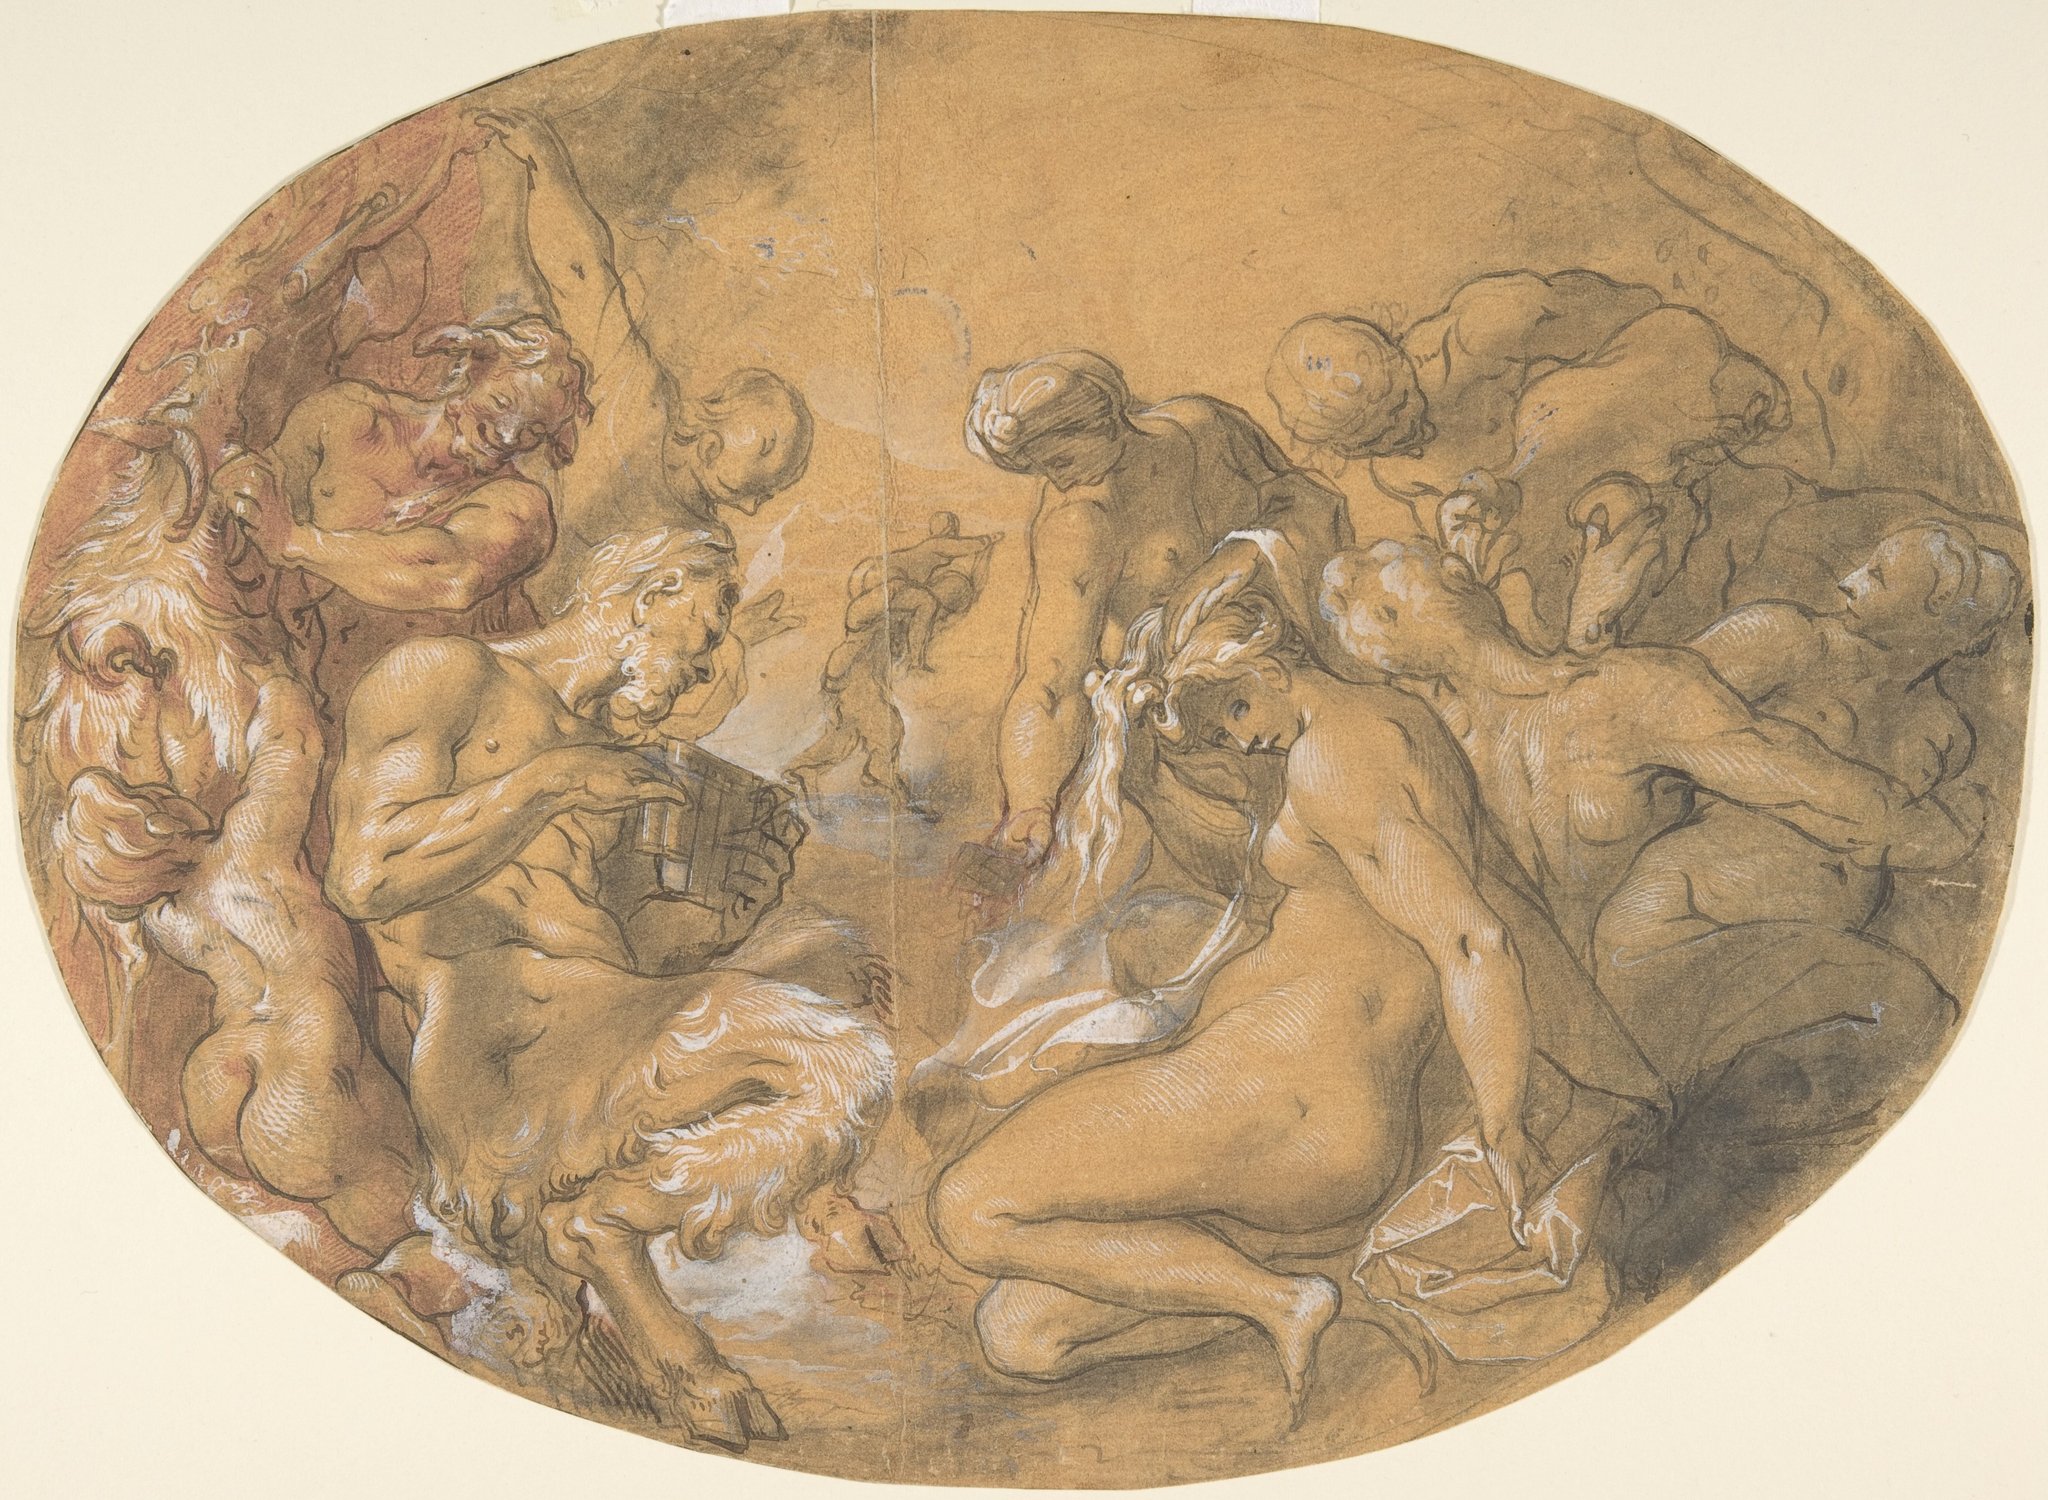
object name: drawing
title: Satyrs and Nymphs; verso: partial counterproof of Heintz's "Studies for the Flight into Egypt" in The Courtauld Gallery, London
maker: joseph heintz the elder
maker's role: artist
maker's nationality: swiss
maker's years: 1564-1609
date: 1599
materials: chalk, gouache, graphite, ink, paper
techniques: brush, drawing, heightening, incising, wash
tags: nymphs,satyrs